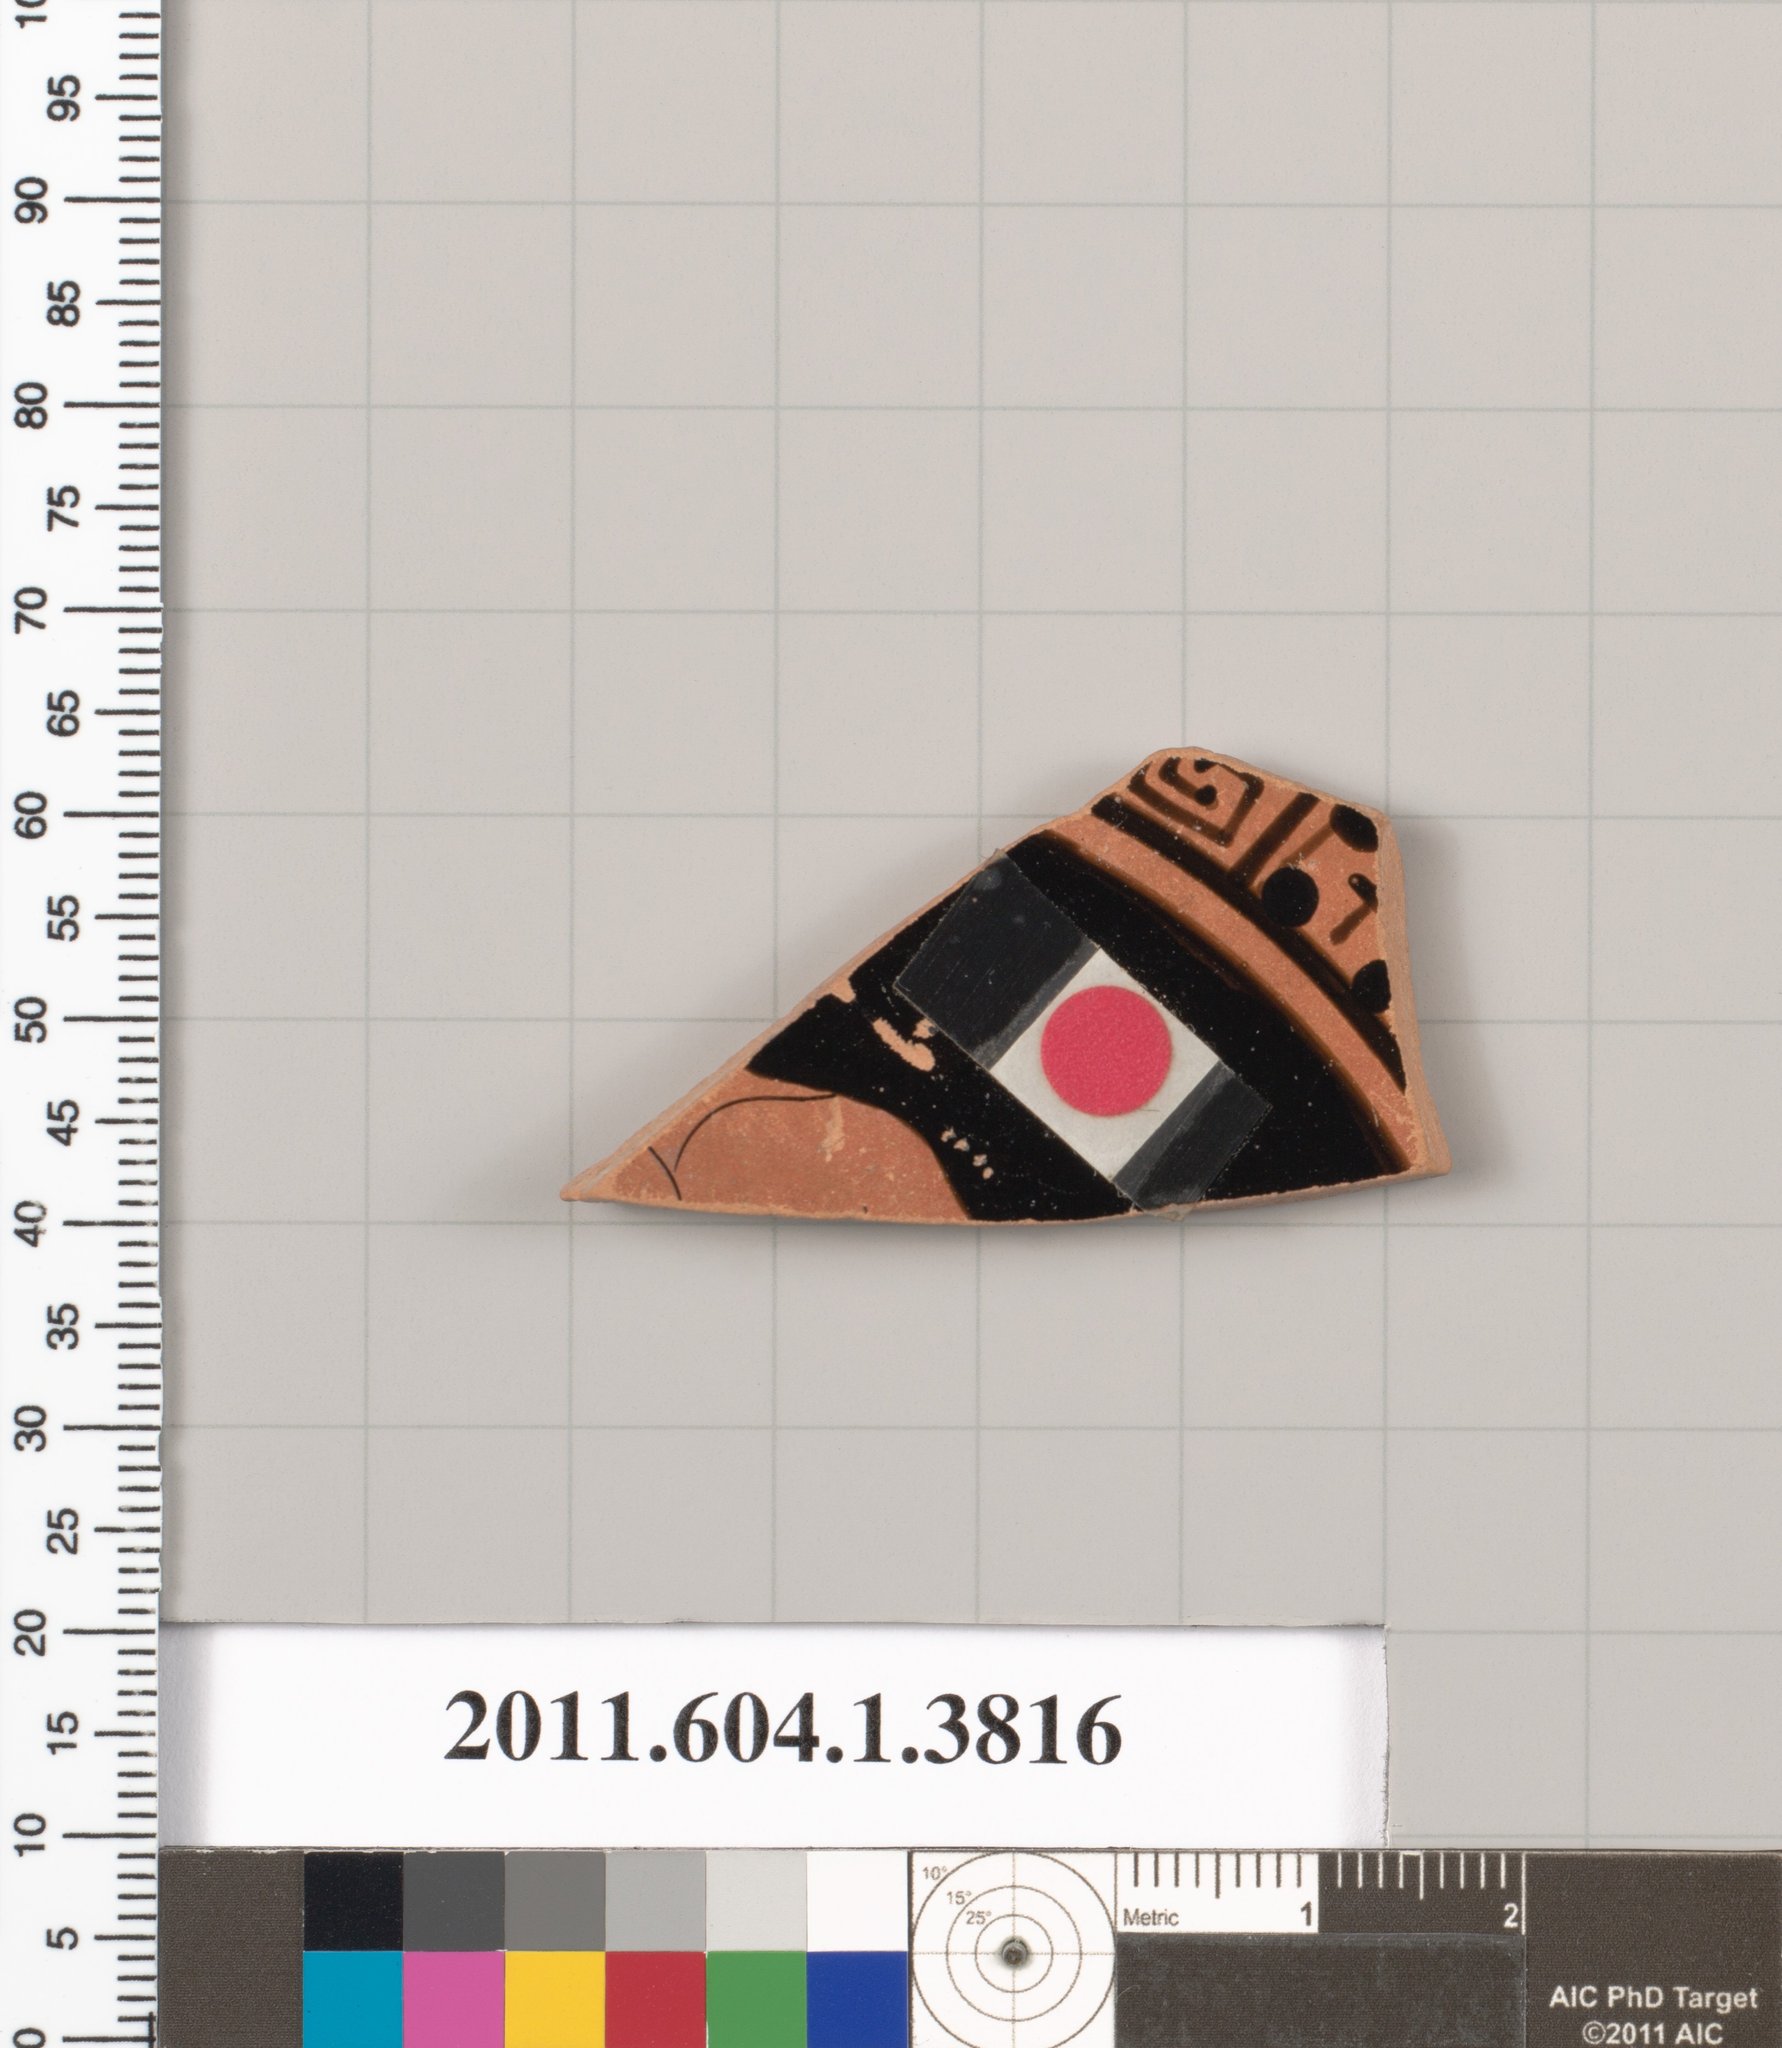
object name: kylix fragment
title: Terracotta fragment of a kylix (drinking cup)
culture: greek, attic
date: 475-451 BCE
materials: terracotta